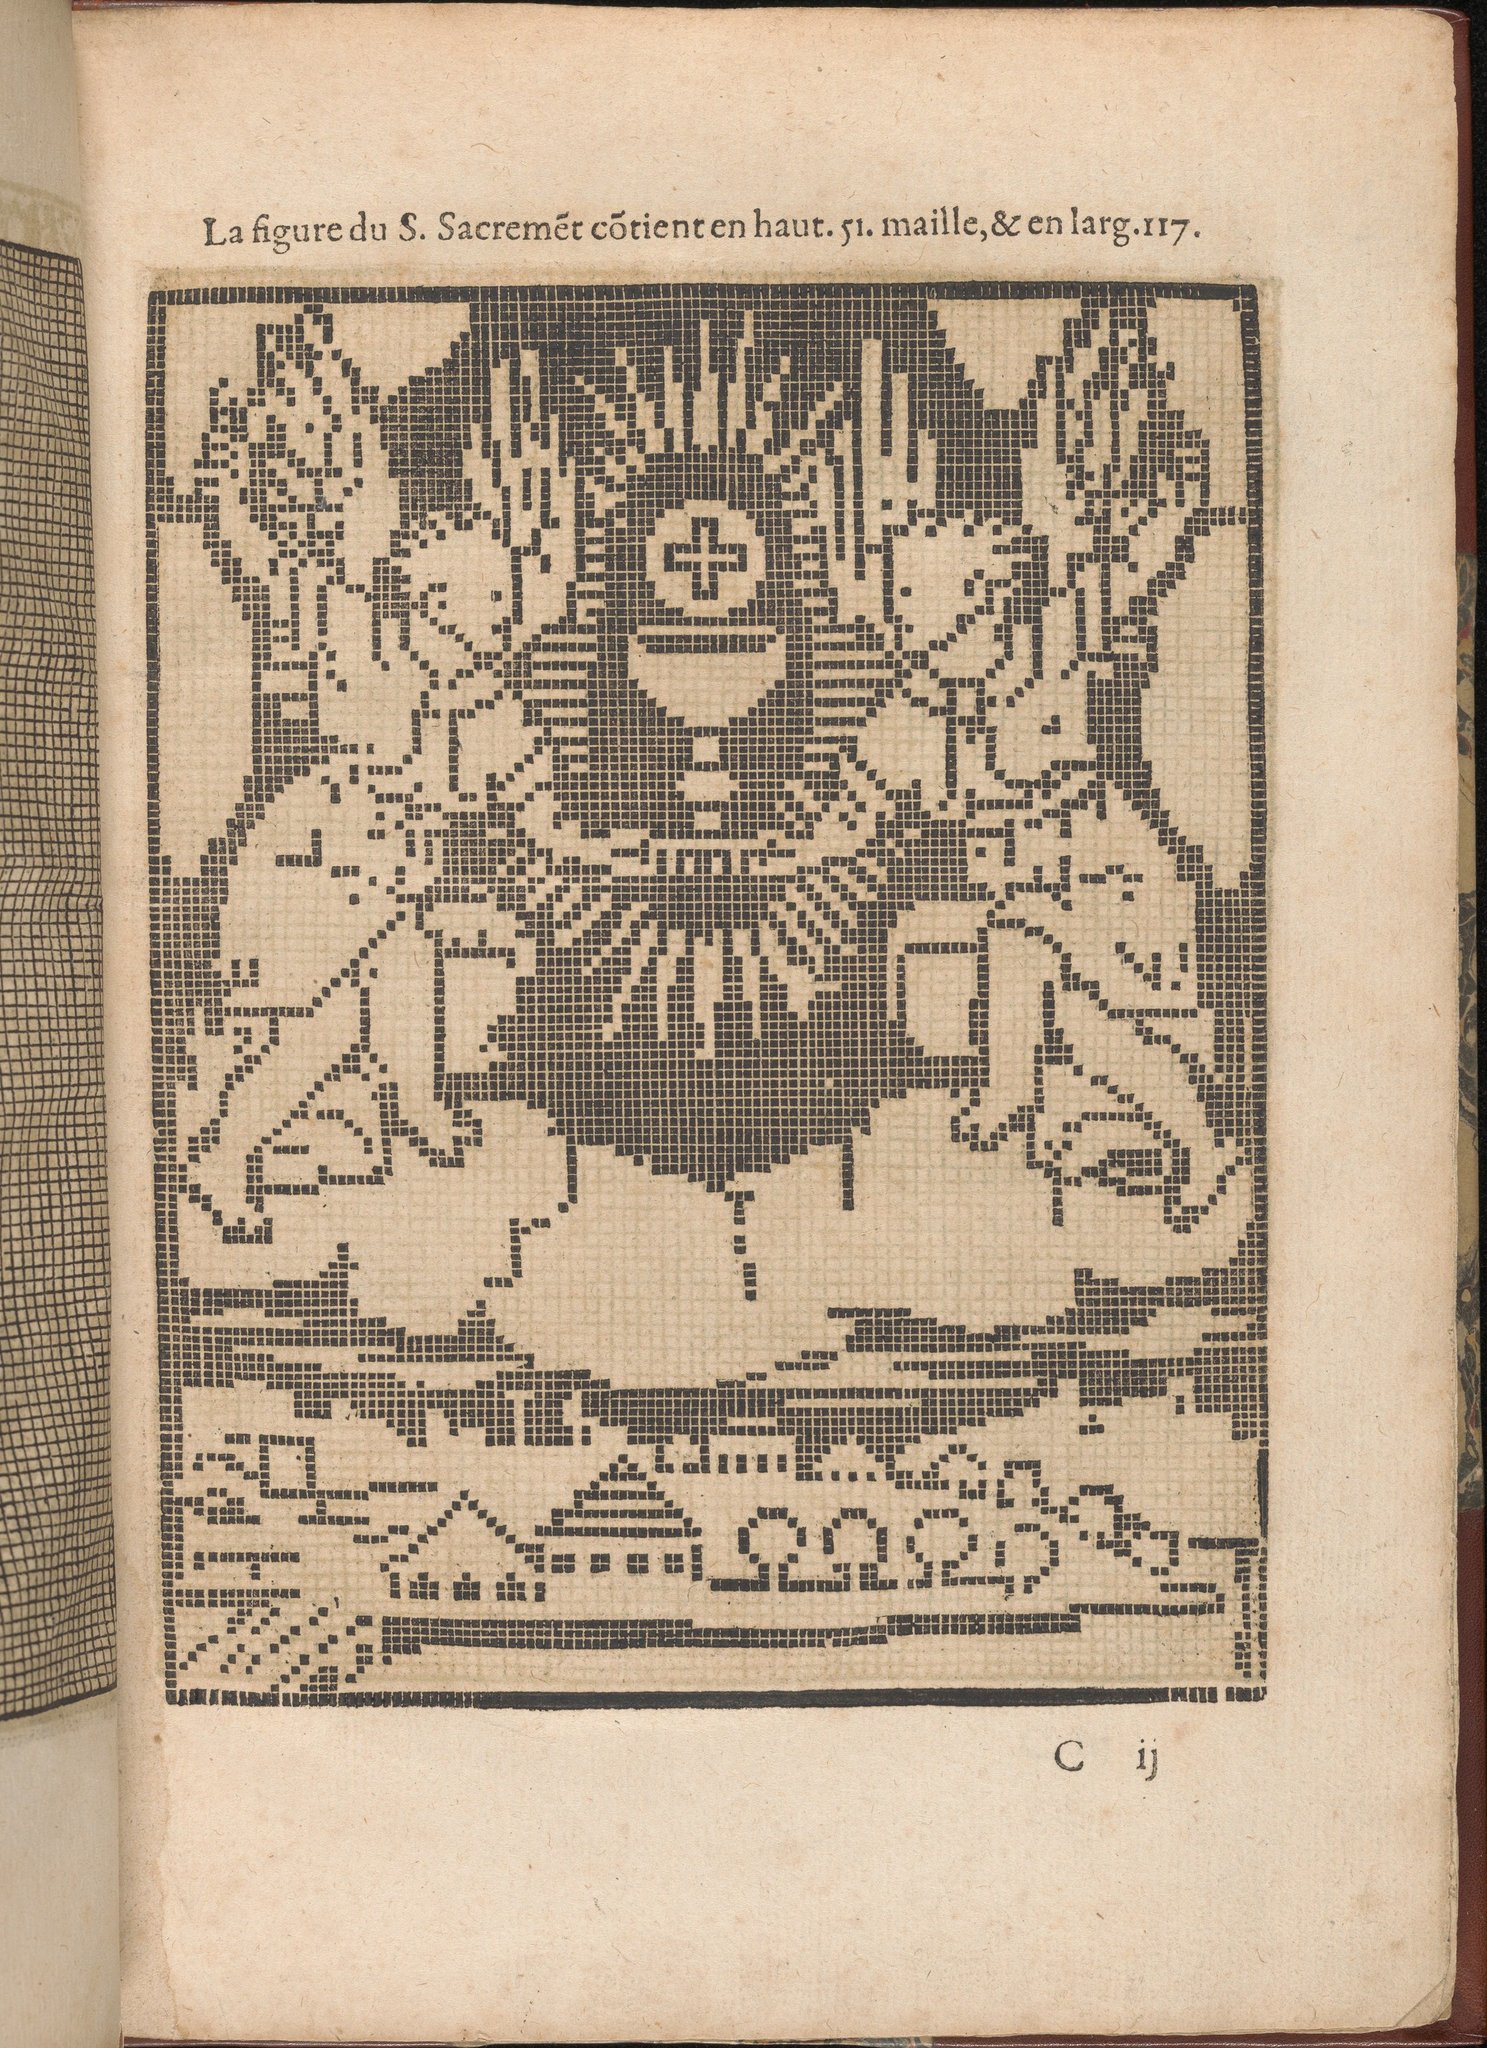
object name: book print ornament architecture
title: Les Secondes Oeuvres, et Subtiles Inventions De Lingerie du Seigneur Federic de Vinciolo Venitien, page 10 (recto)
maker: federico de vinciolo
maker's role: designer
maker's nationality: italian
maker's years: 1582-1599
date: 1603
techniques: woodcut